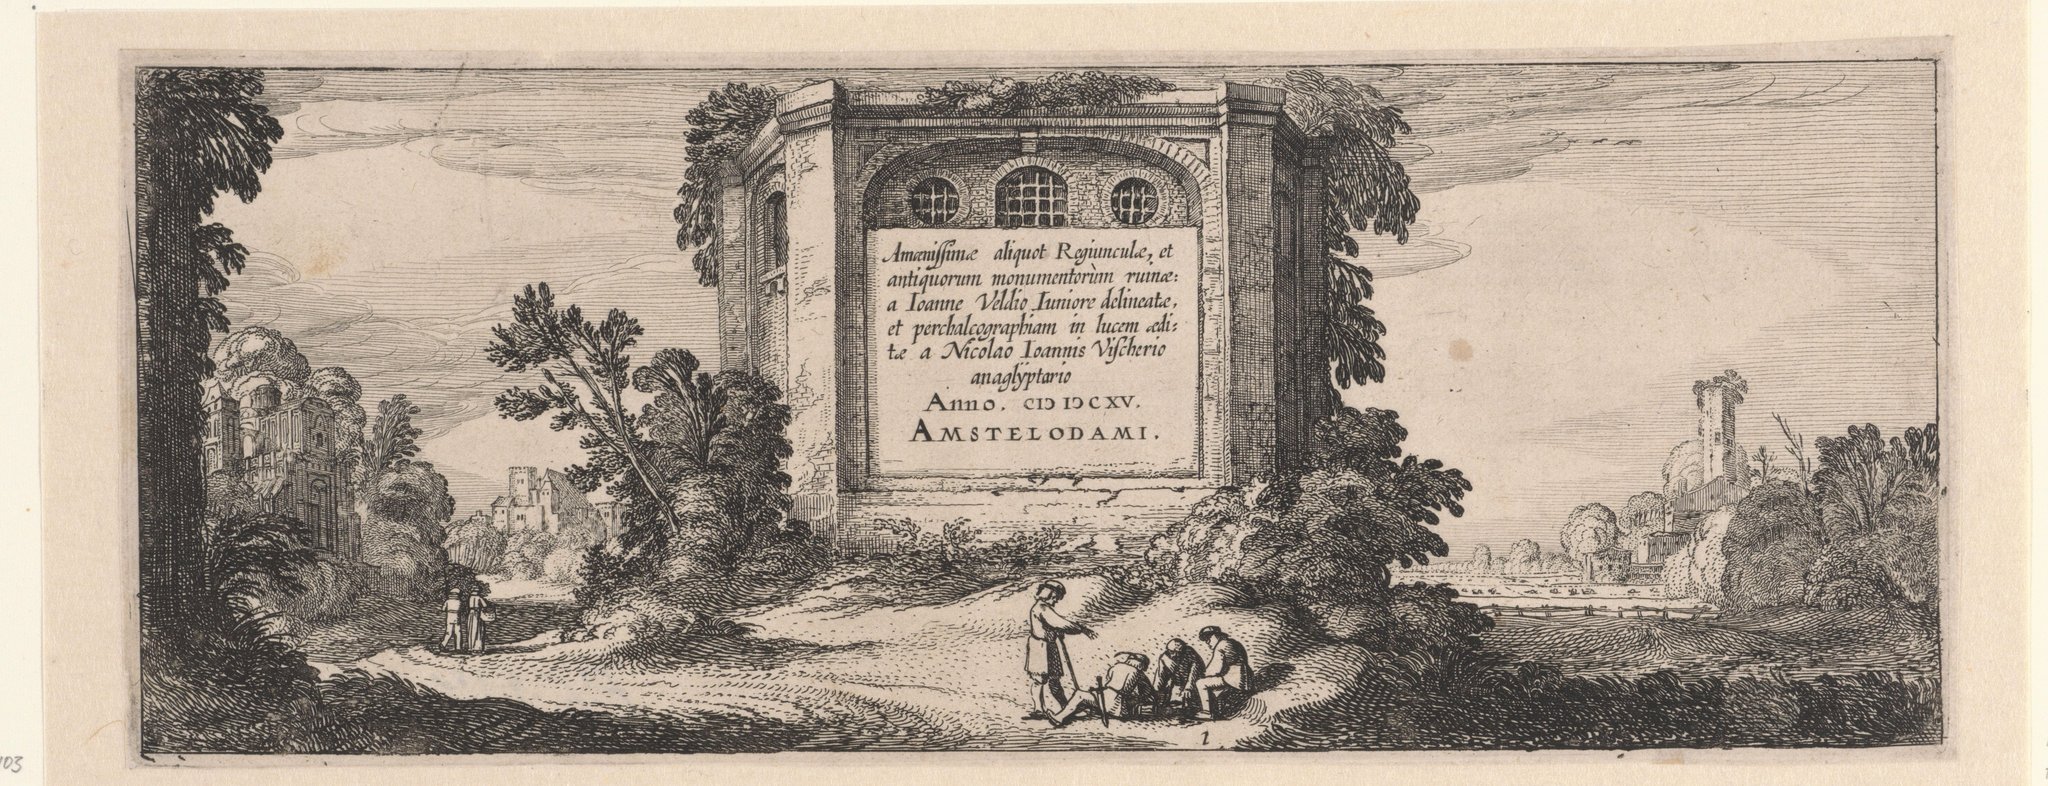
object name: print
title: Figuren bij een hexagonaal gebouw in een landschap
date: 1615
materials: paper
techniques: etching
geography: amsterdam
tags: landscape with tower or castle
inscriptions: collector's mark: Lugt 240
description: Figuren bij een hexagonaal gebouw in een landschap. Eerste prent uit een serie van achttien.